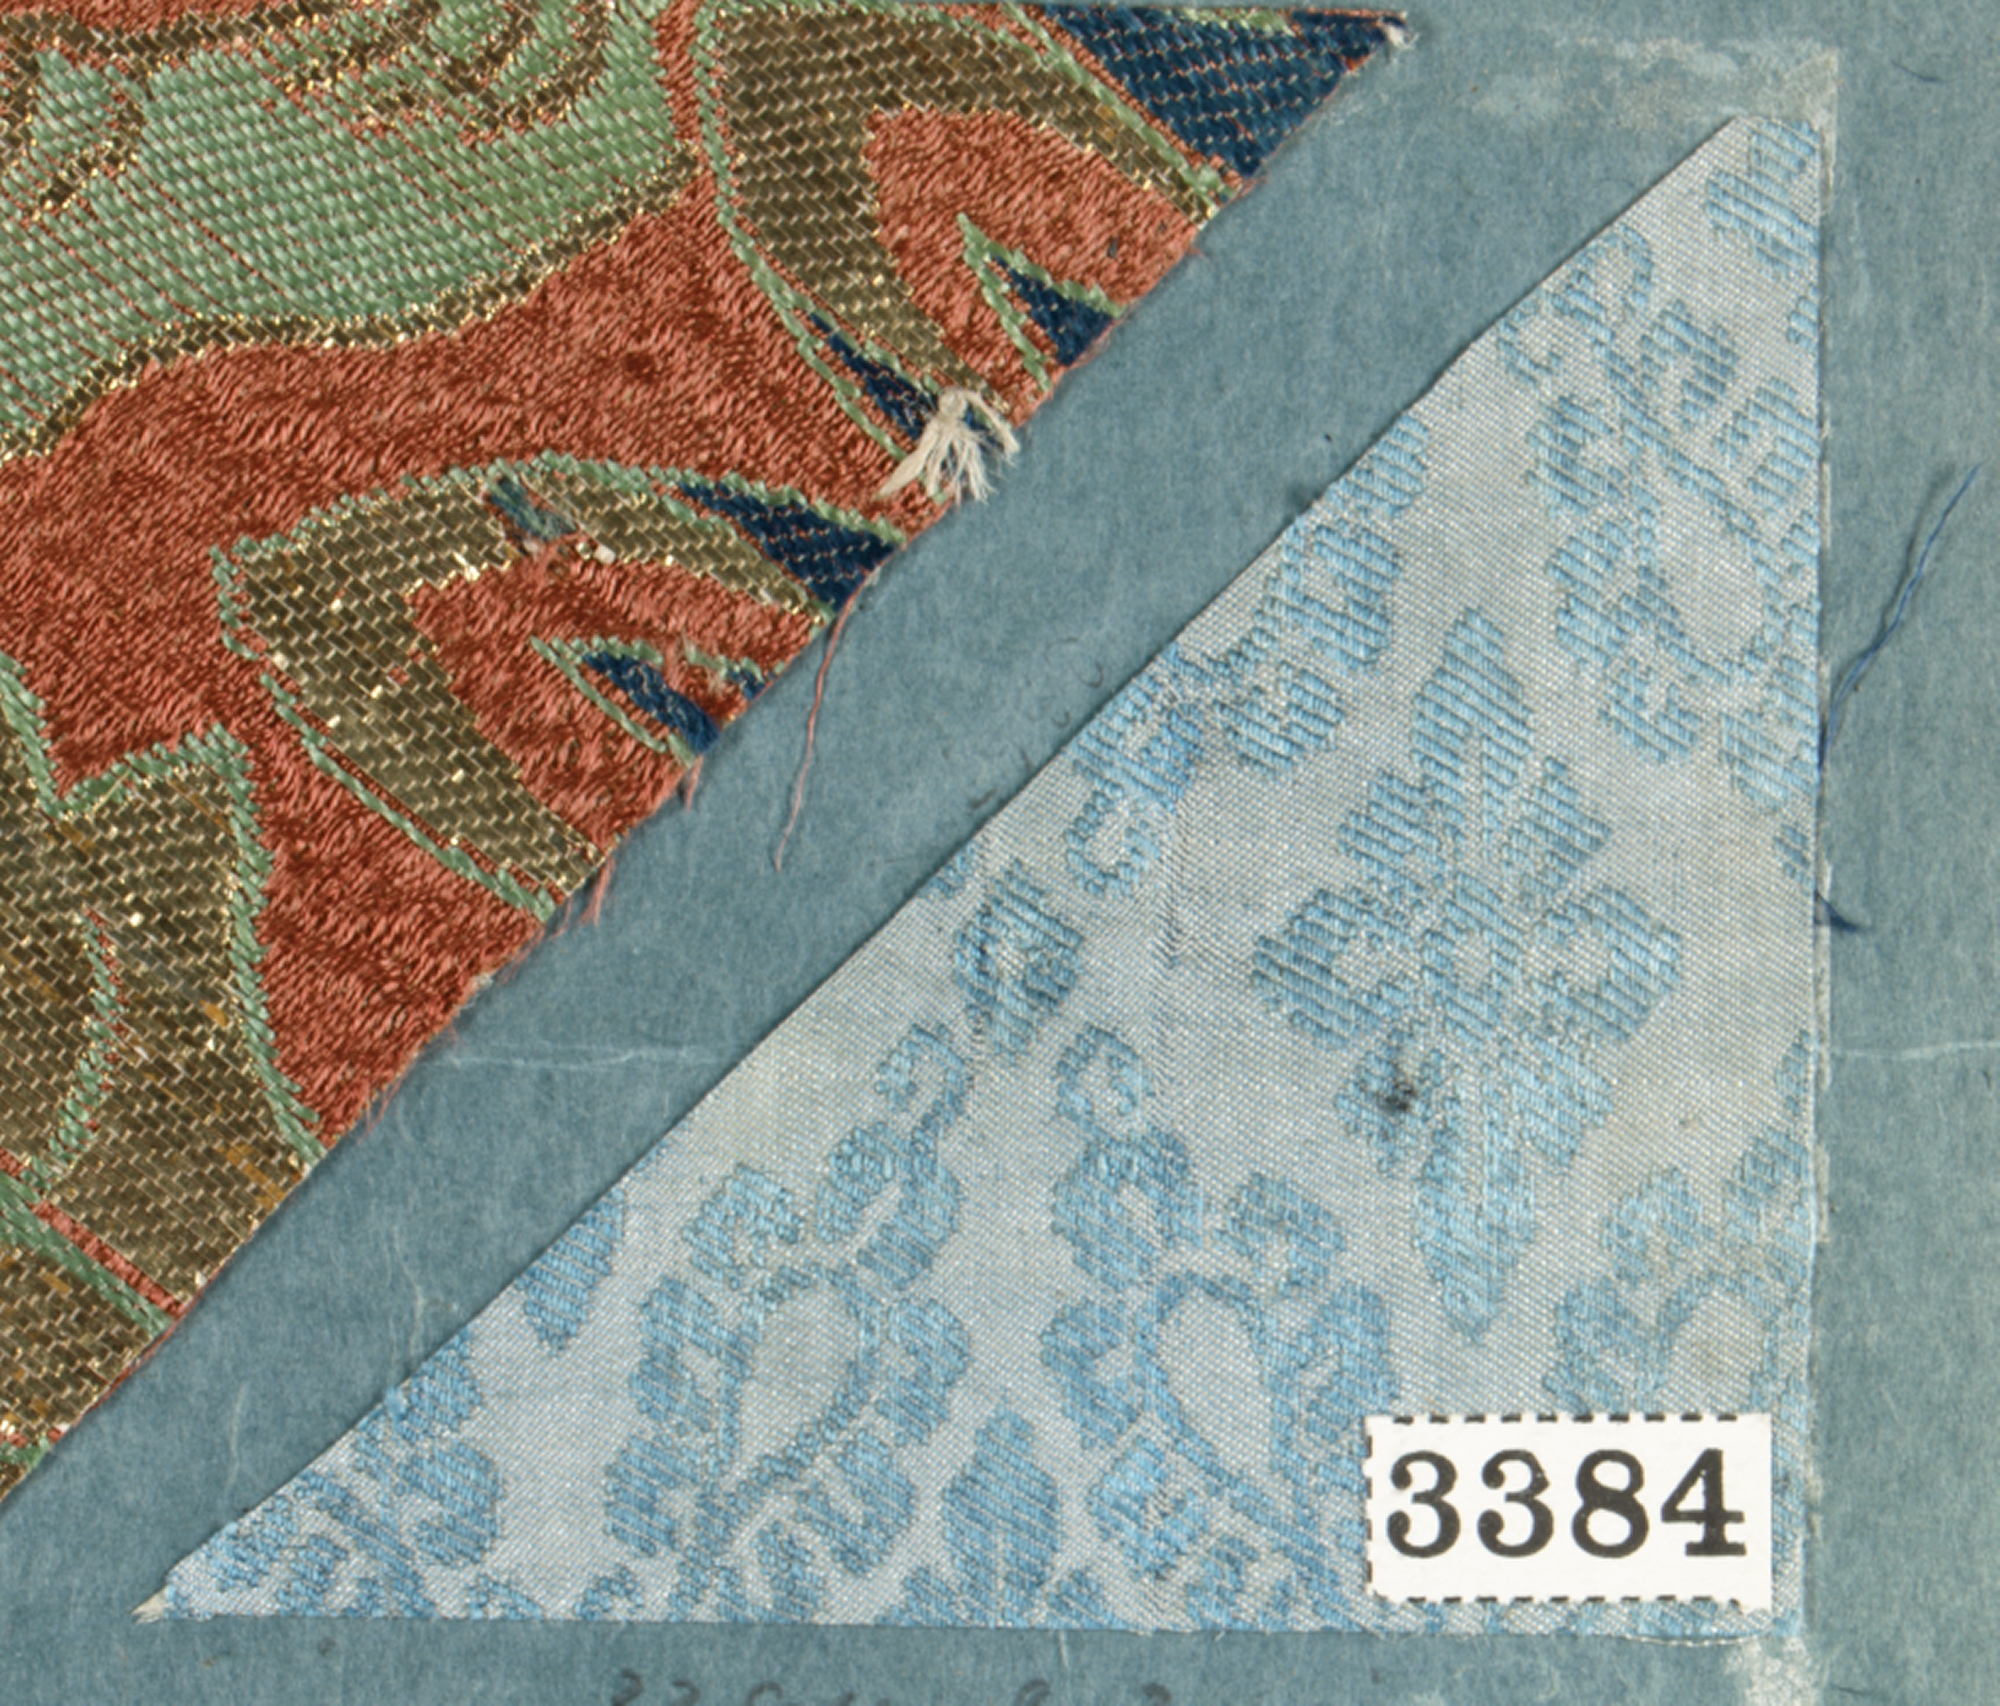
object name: textile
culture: japanese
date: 1801-1900